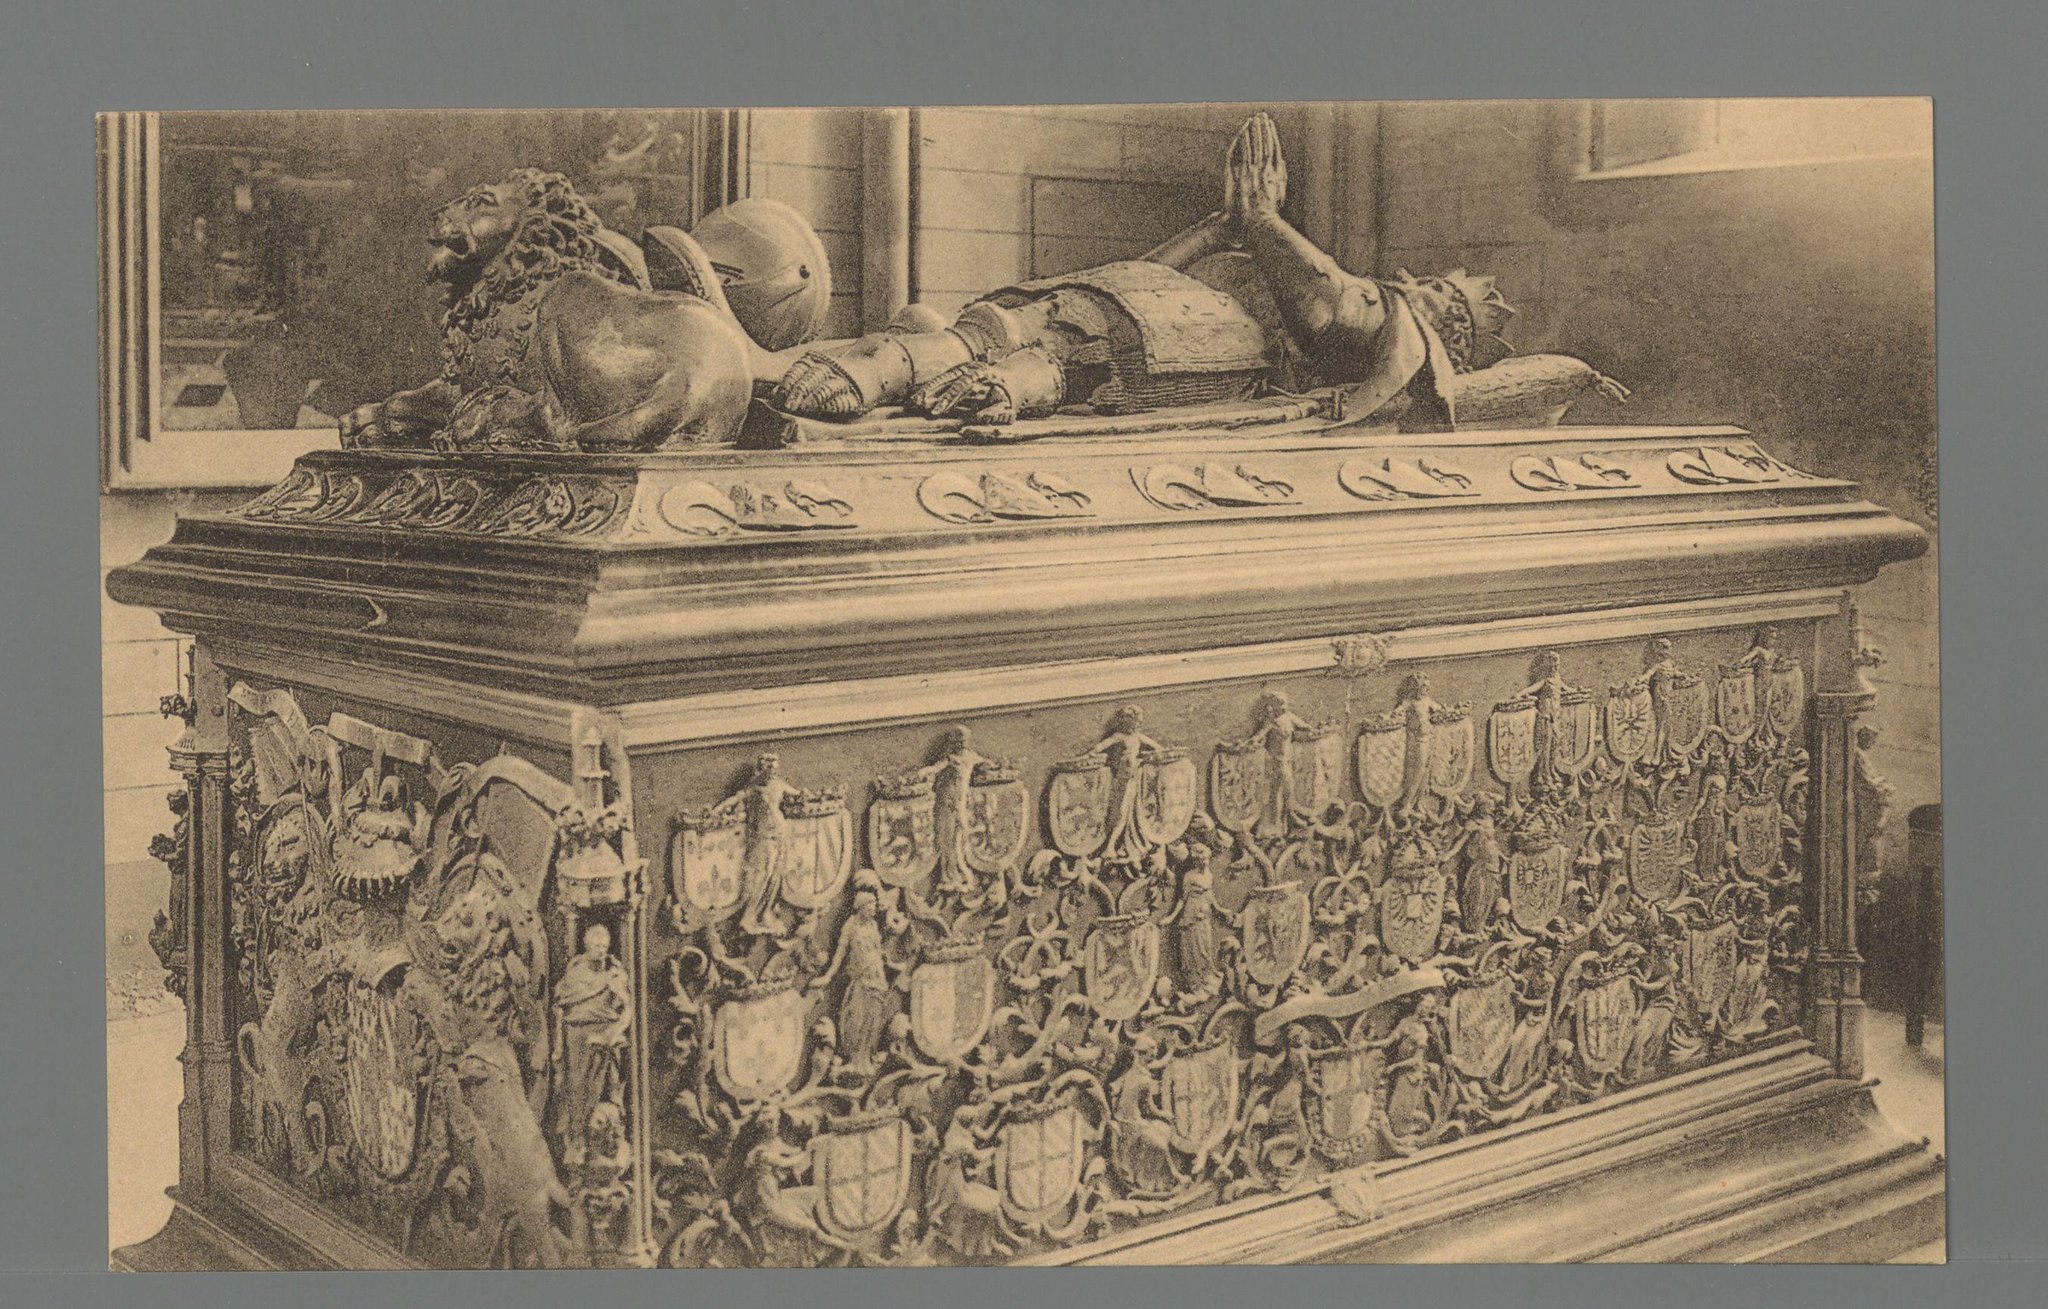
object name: ansichtkaart, prentbriefkaart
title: Bruges / Brugge / Eglise Notre-Dame. Tombeau de Charles le Téméraire / O.-L. Vrouwkerk. Graf van Karel de Stoute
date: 1913-1930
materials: cardboard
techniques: photograph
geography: brussels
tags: grave, tomb, interior of church